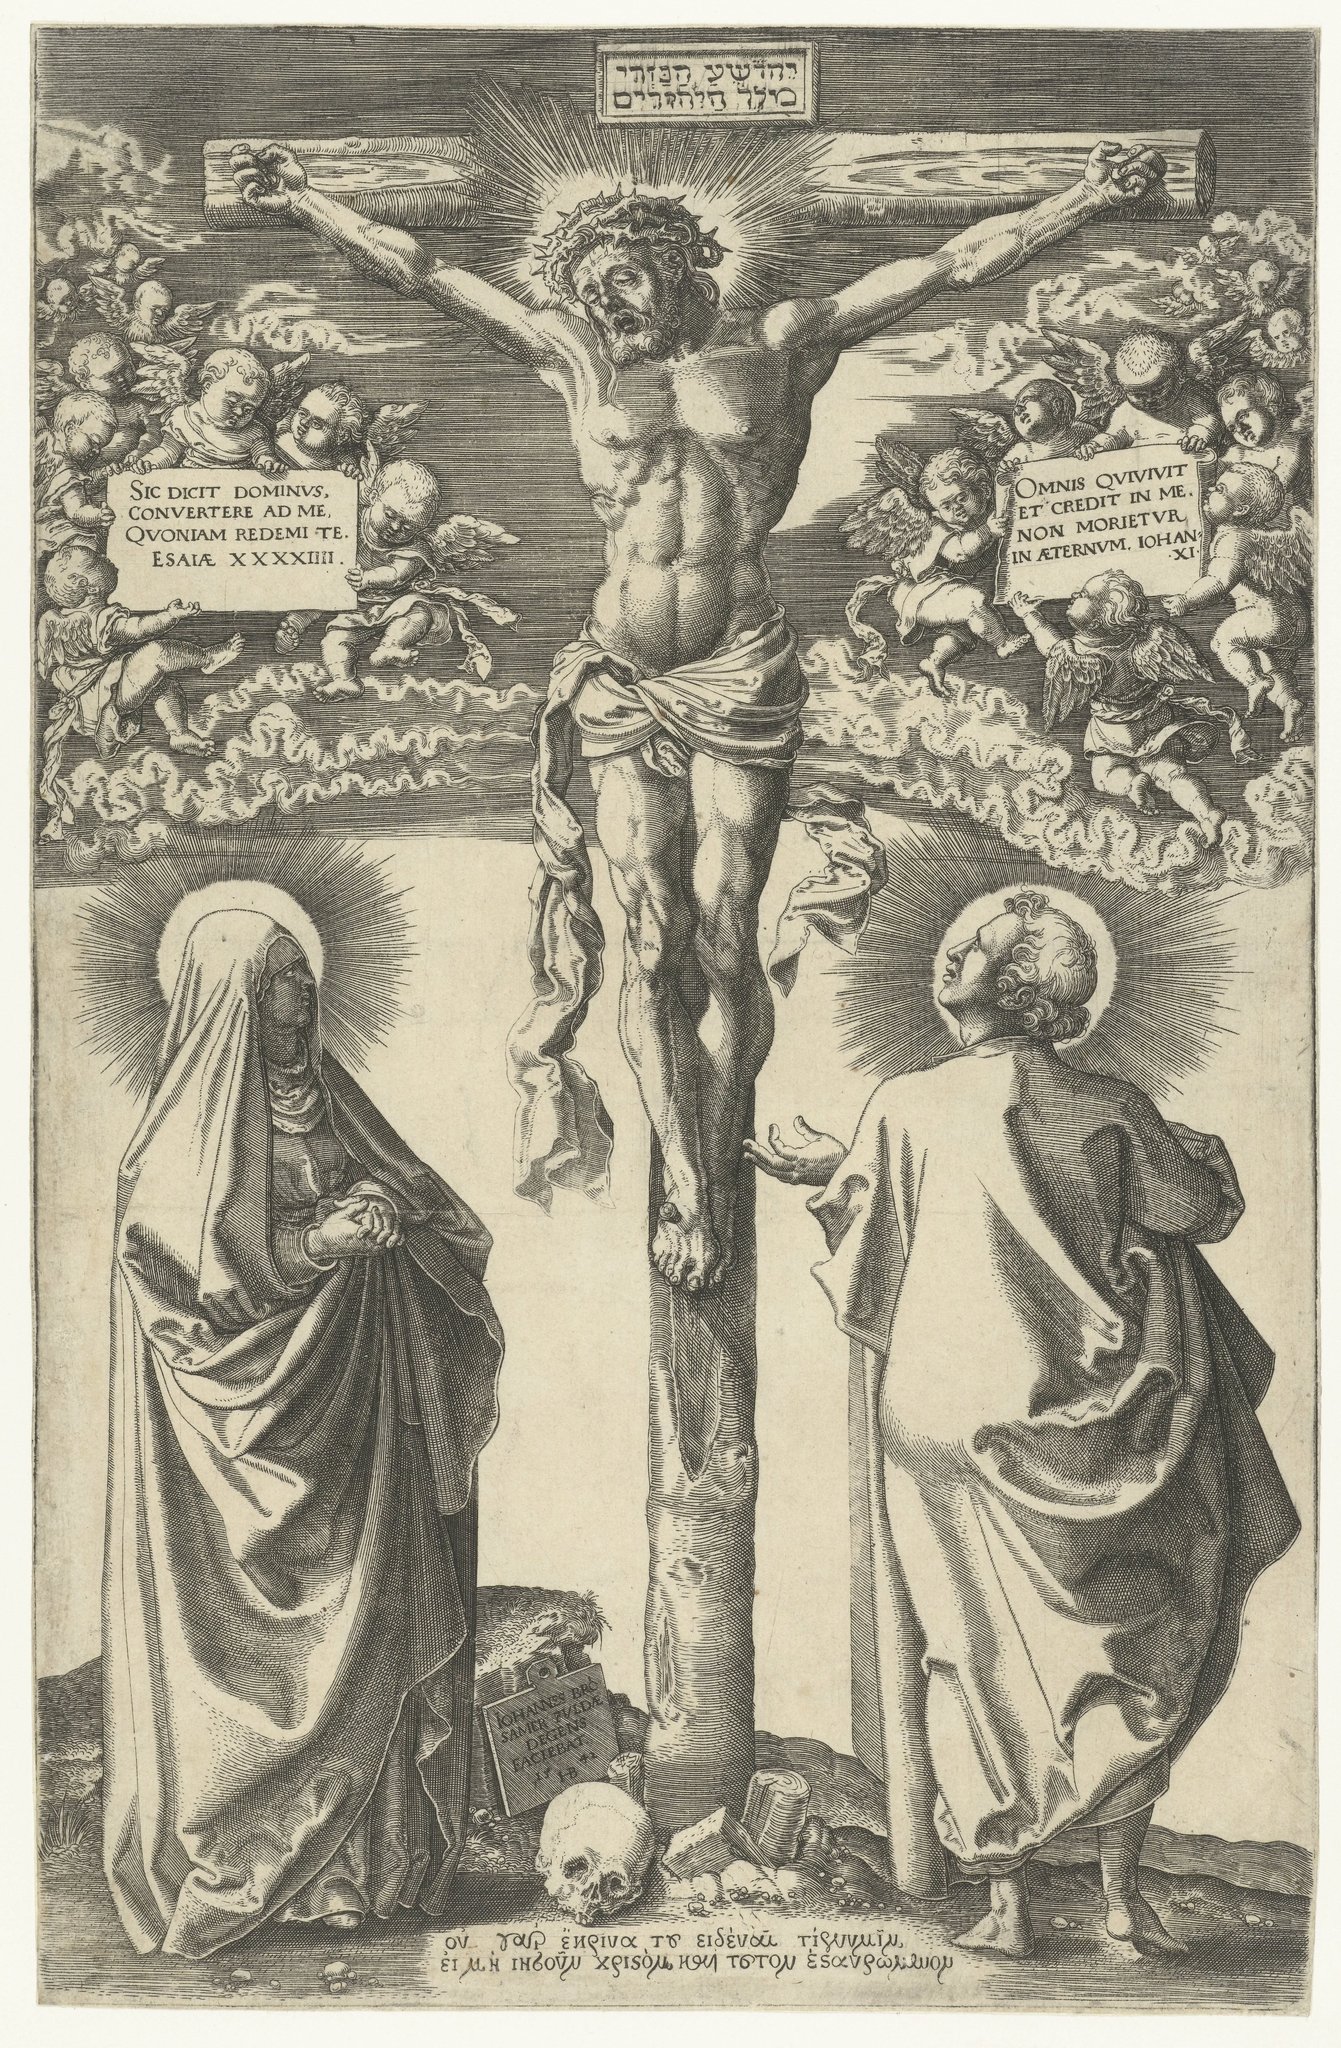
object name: print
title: Christus aan het kruis tussen Maria en Johannes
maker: hans brosamer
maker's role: print maker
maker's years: 1500-1554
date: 1542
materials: paper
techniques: engraving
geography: fulda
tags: crucified christ with mary and john on either side of the cross; holy rood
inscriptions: collector's mark: Lugt 2773, collector's mark: Lugt 2770, collector's mark: Lugt 2228a, collector's mark: Lugt 2760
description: Christus aan het kruis tussen Maria en Johannes. Twee Latijnse teksten van Esaias en Johannes worden gedragen door engelen in de hemel, boven het kruis staat een Hebreewse tekst en onder het kruis twee Griekse regels.